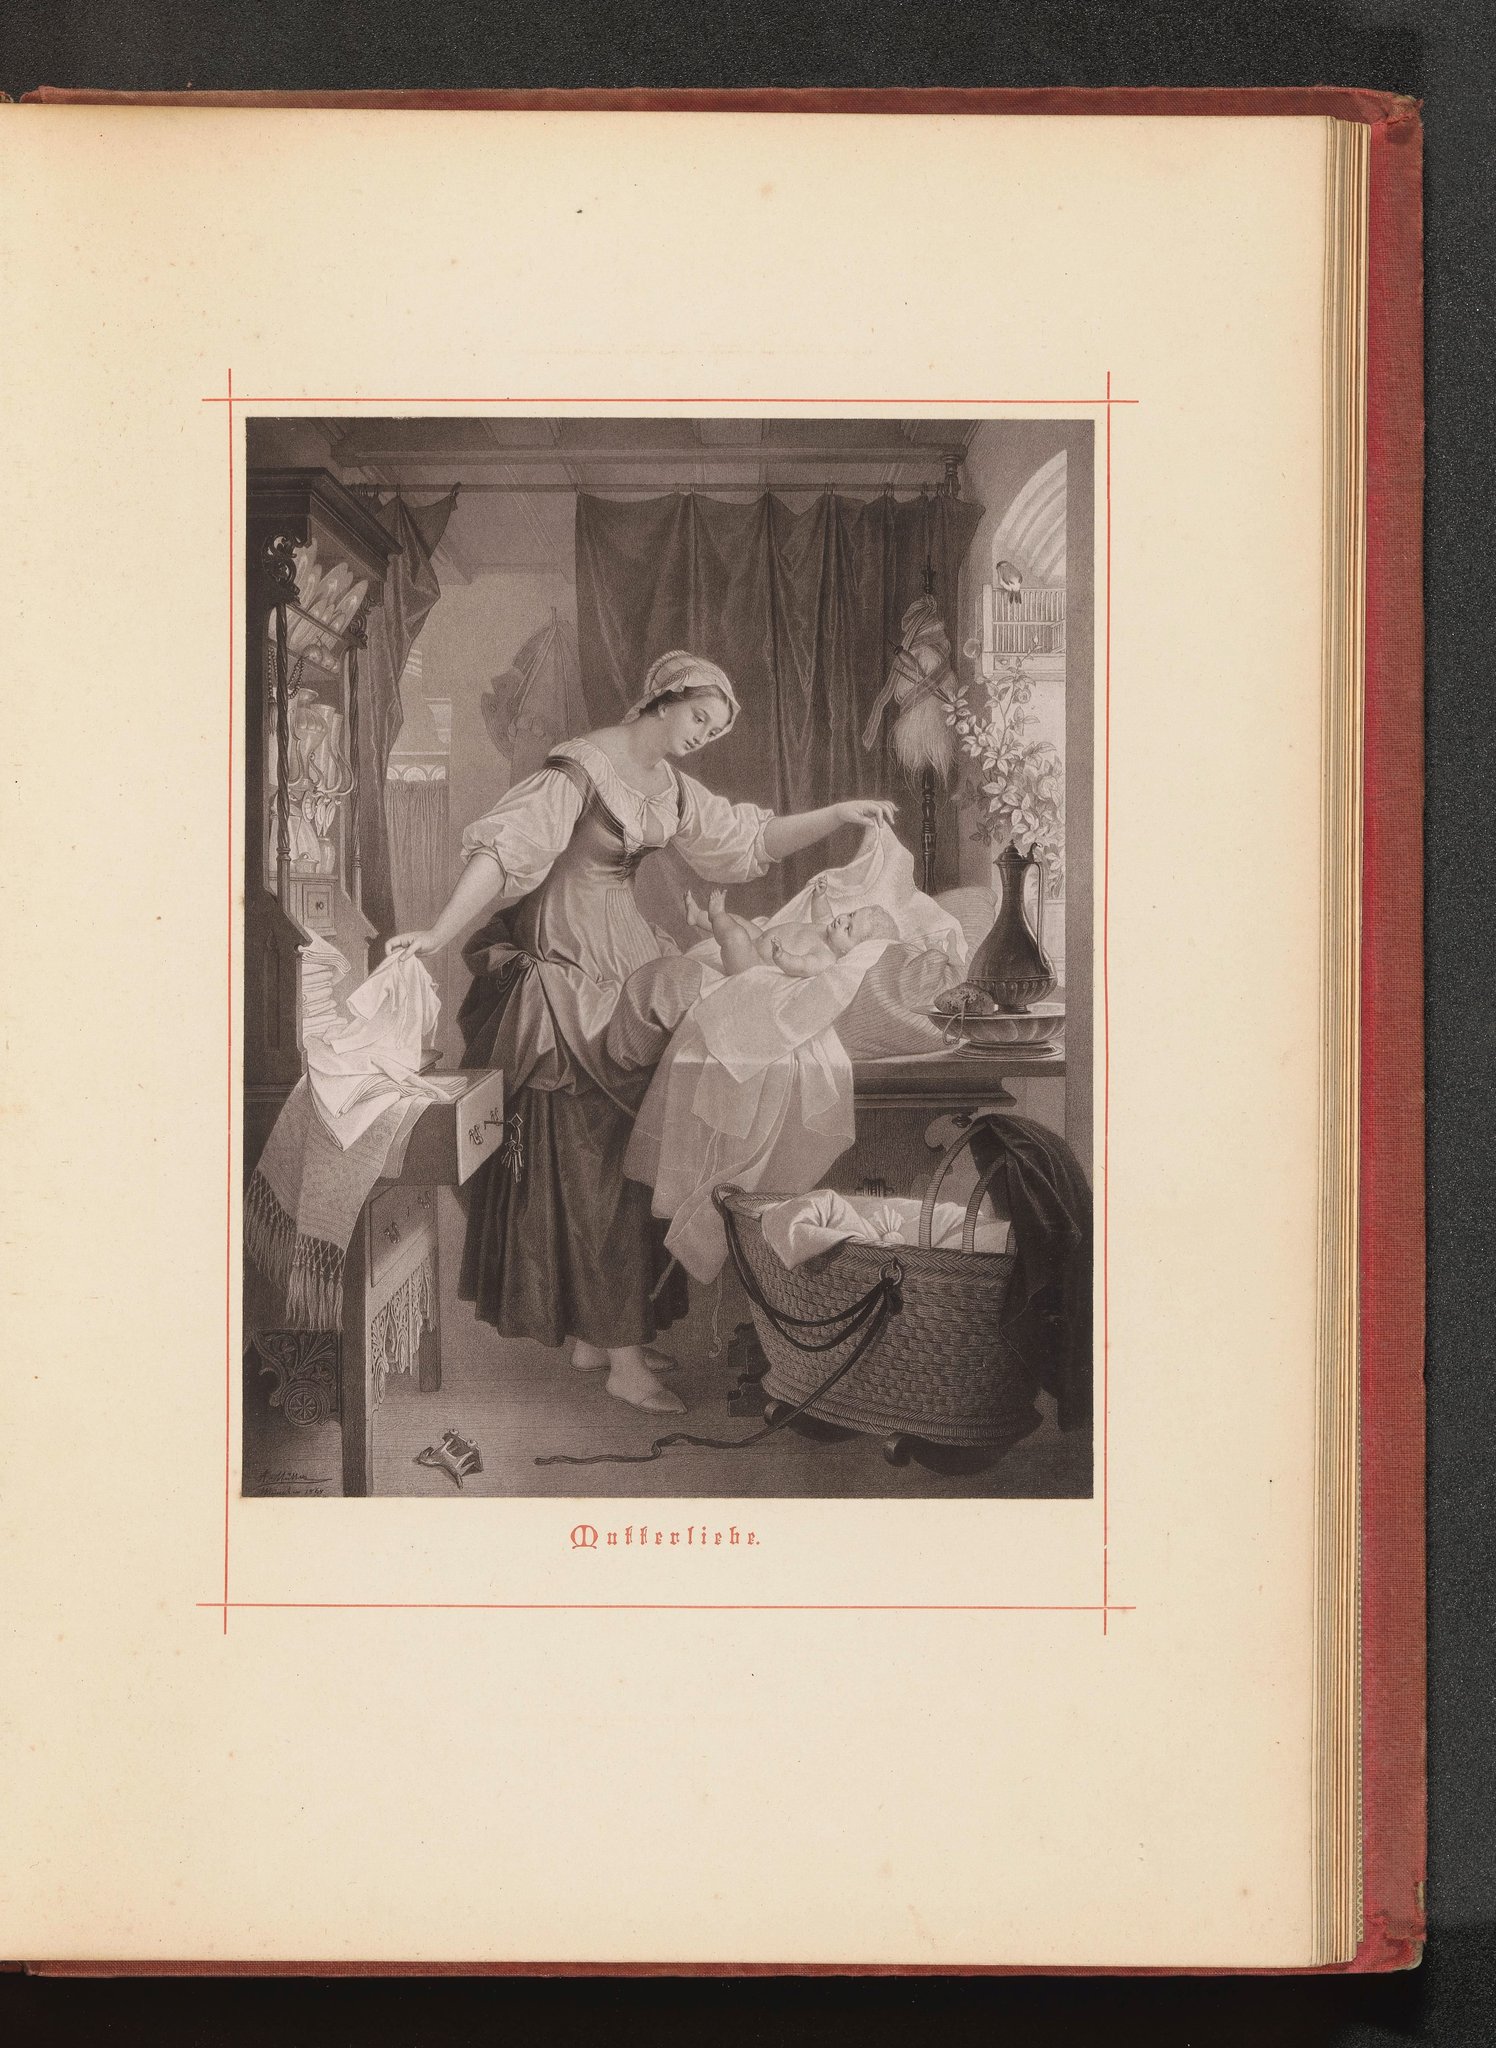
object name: reproduction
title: Mutterliebe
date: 1871-1881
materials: paper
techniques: photograph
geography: germany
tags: taking care of children